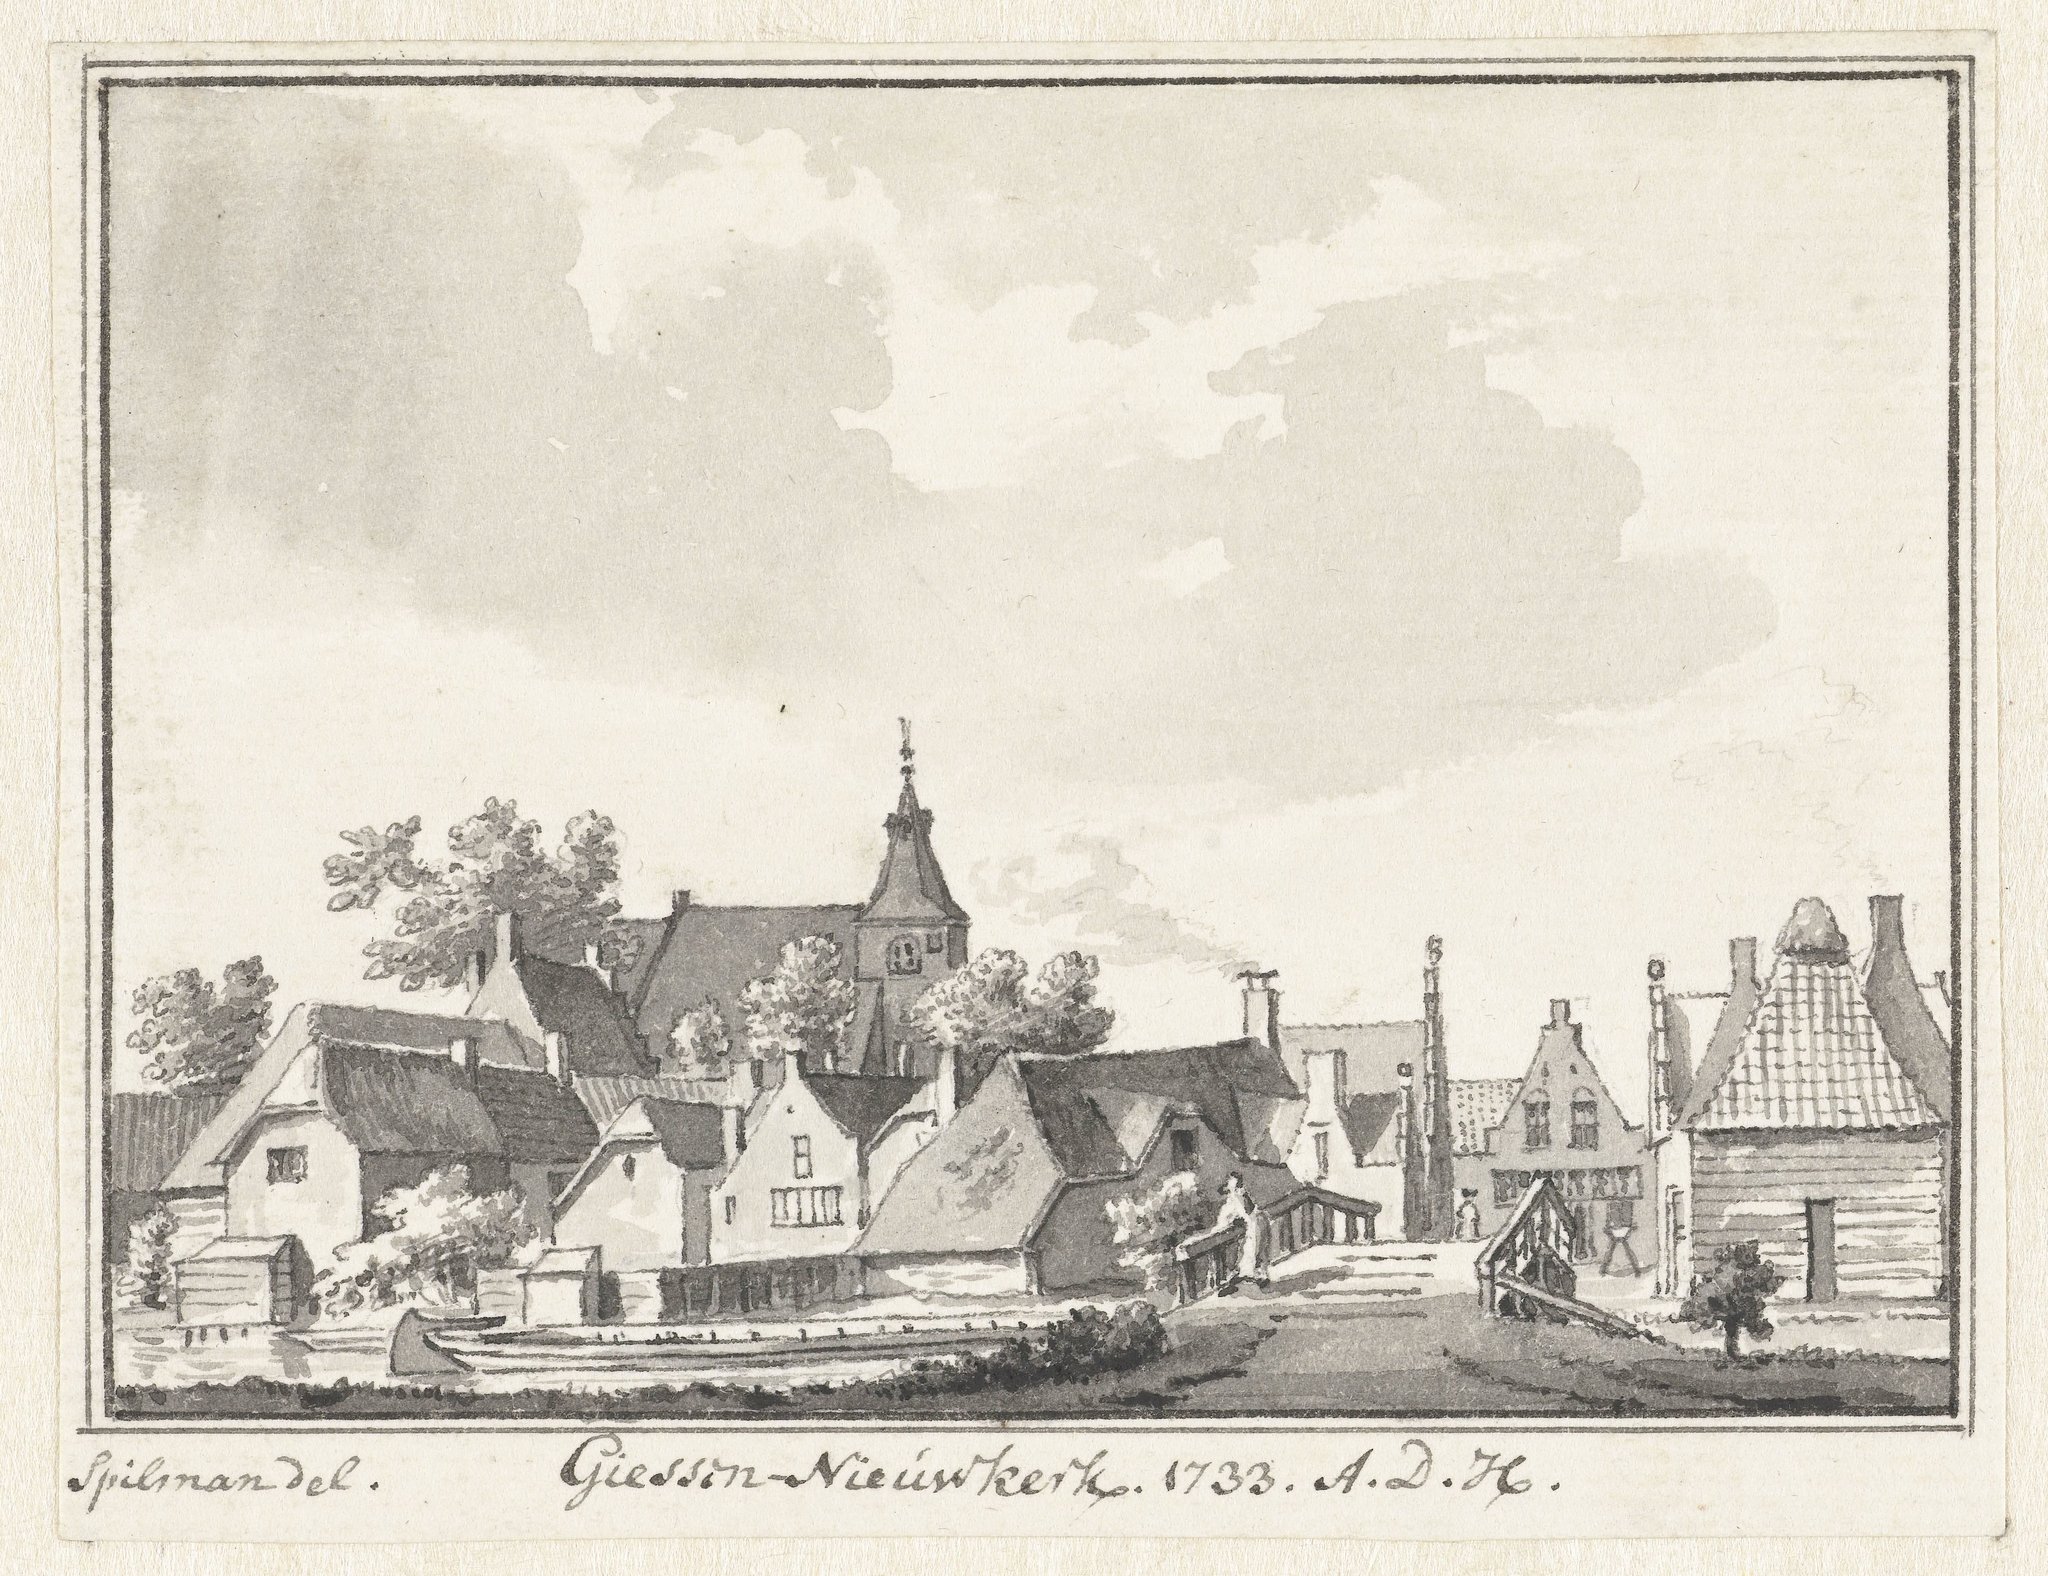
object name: drawing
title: Het dorp Giessen-Nieuwkerk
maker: hendrik spilman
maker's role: draughtsman, painter, print maker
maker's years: 1721-1784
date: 1733-1784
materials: ink, paper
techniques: brush, pen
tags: prospect of village, silhouette of village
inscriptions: inscription: ‘Spilman del. Giessen-Nieuwkerk. 1733. A.D.H.’